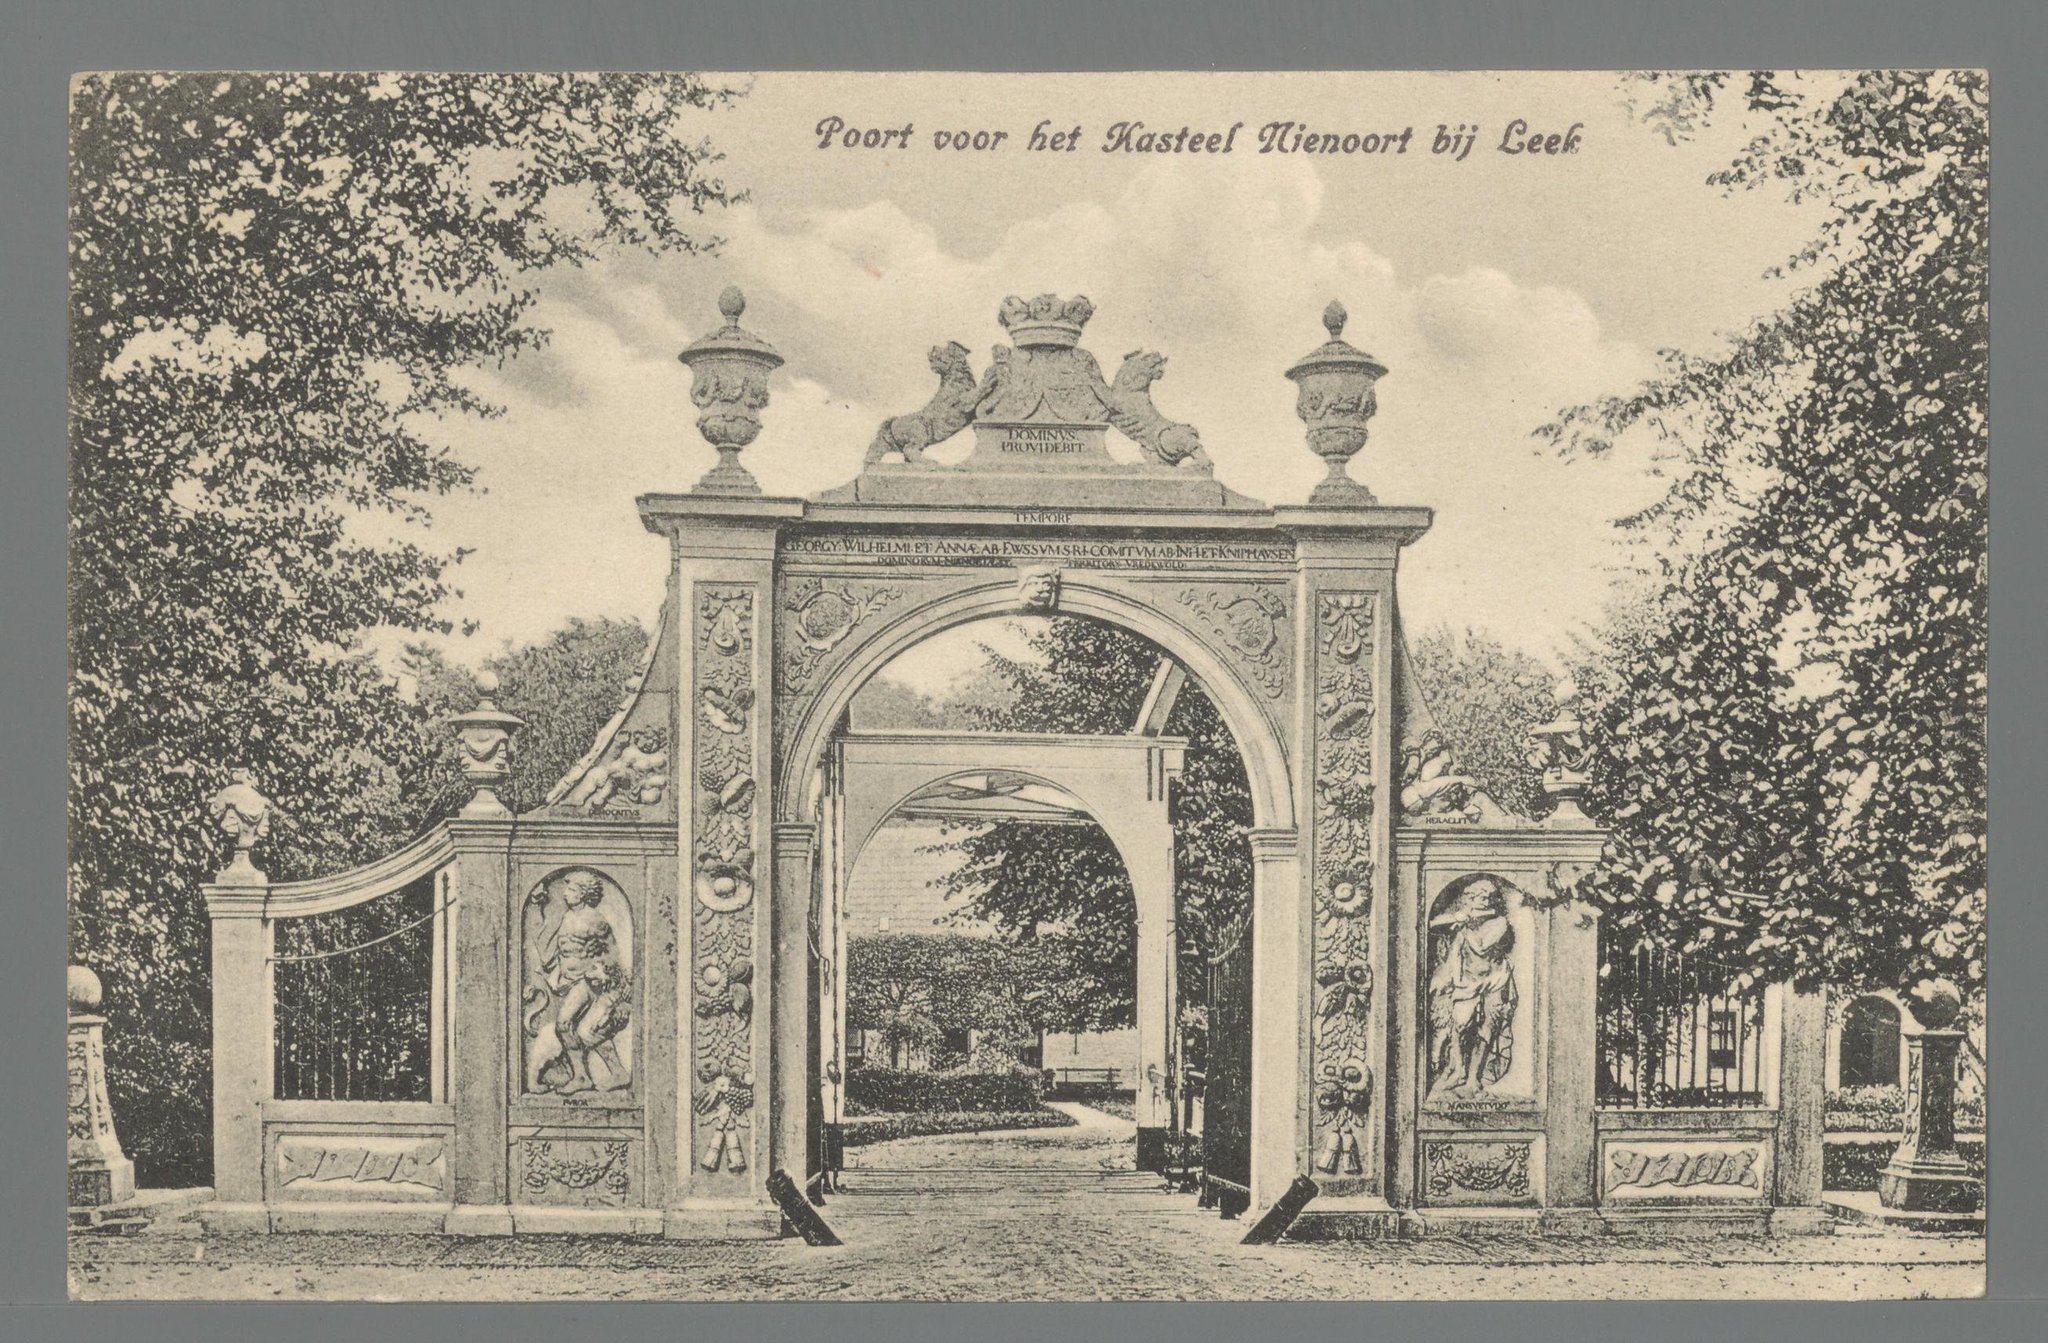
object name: photomechanical print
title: Poort voor het Kasteel Nienoort bij Leek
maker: Anonymous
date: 1905-1930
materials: cardboard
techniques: photograph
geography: leek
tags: castle, gate, entrance